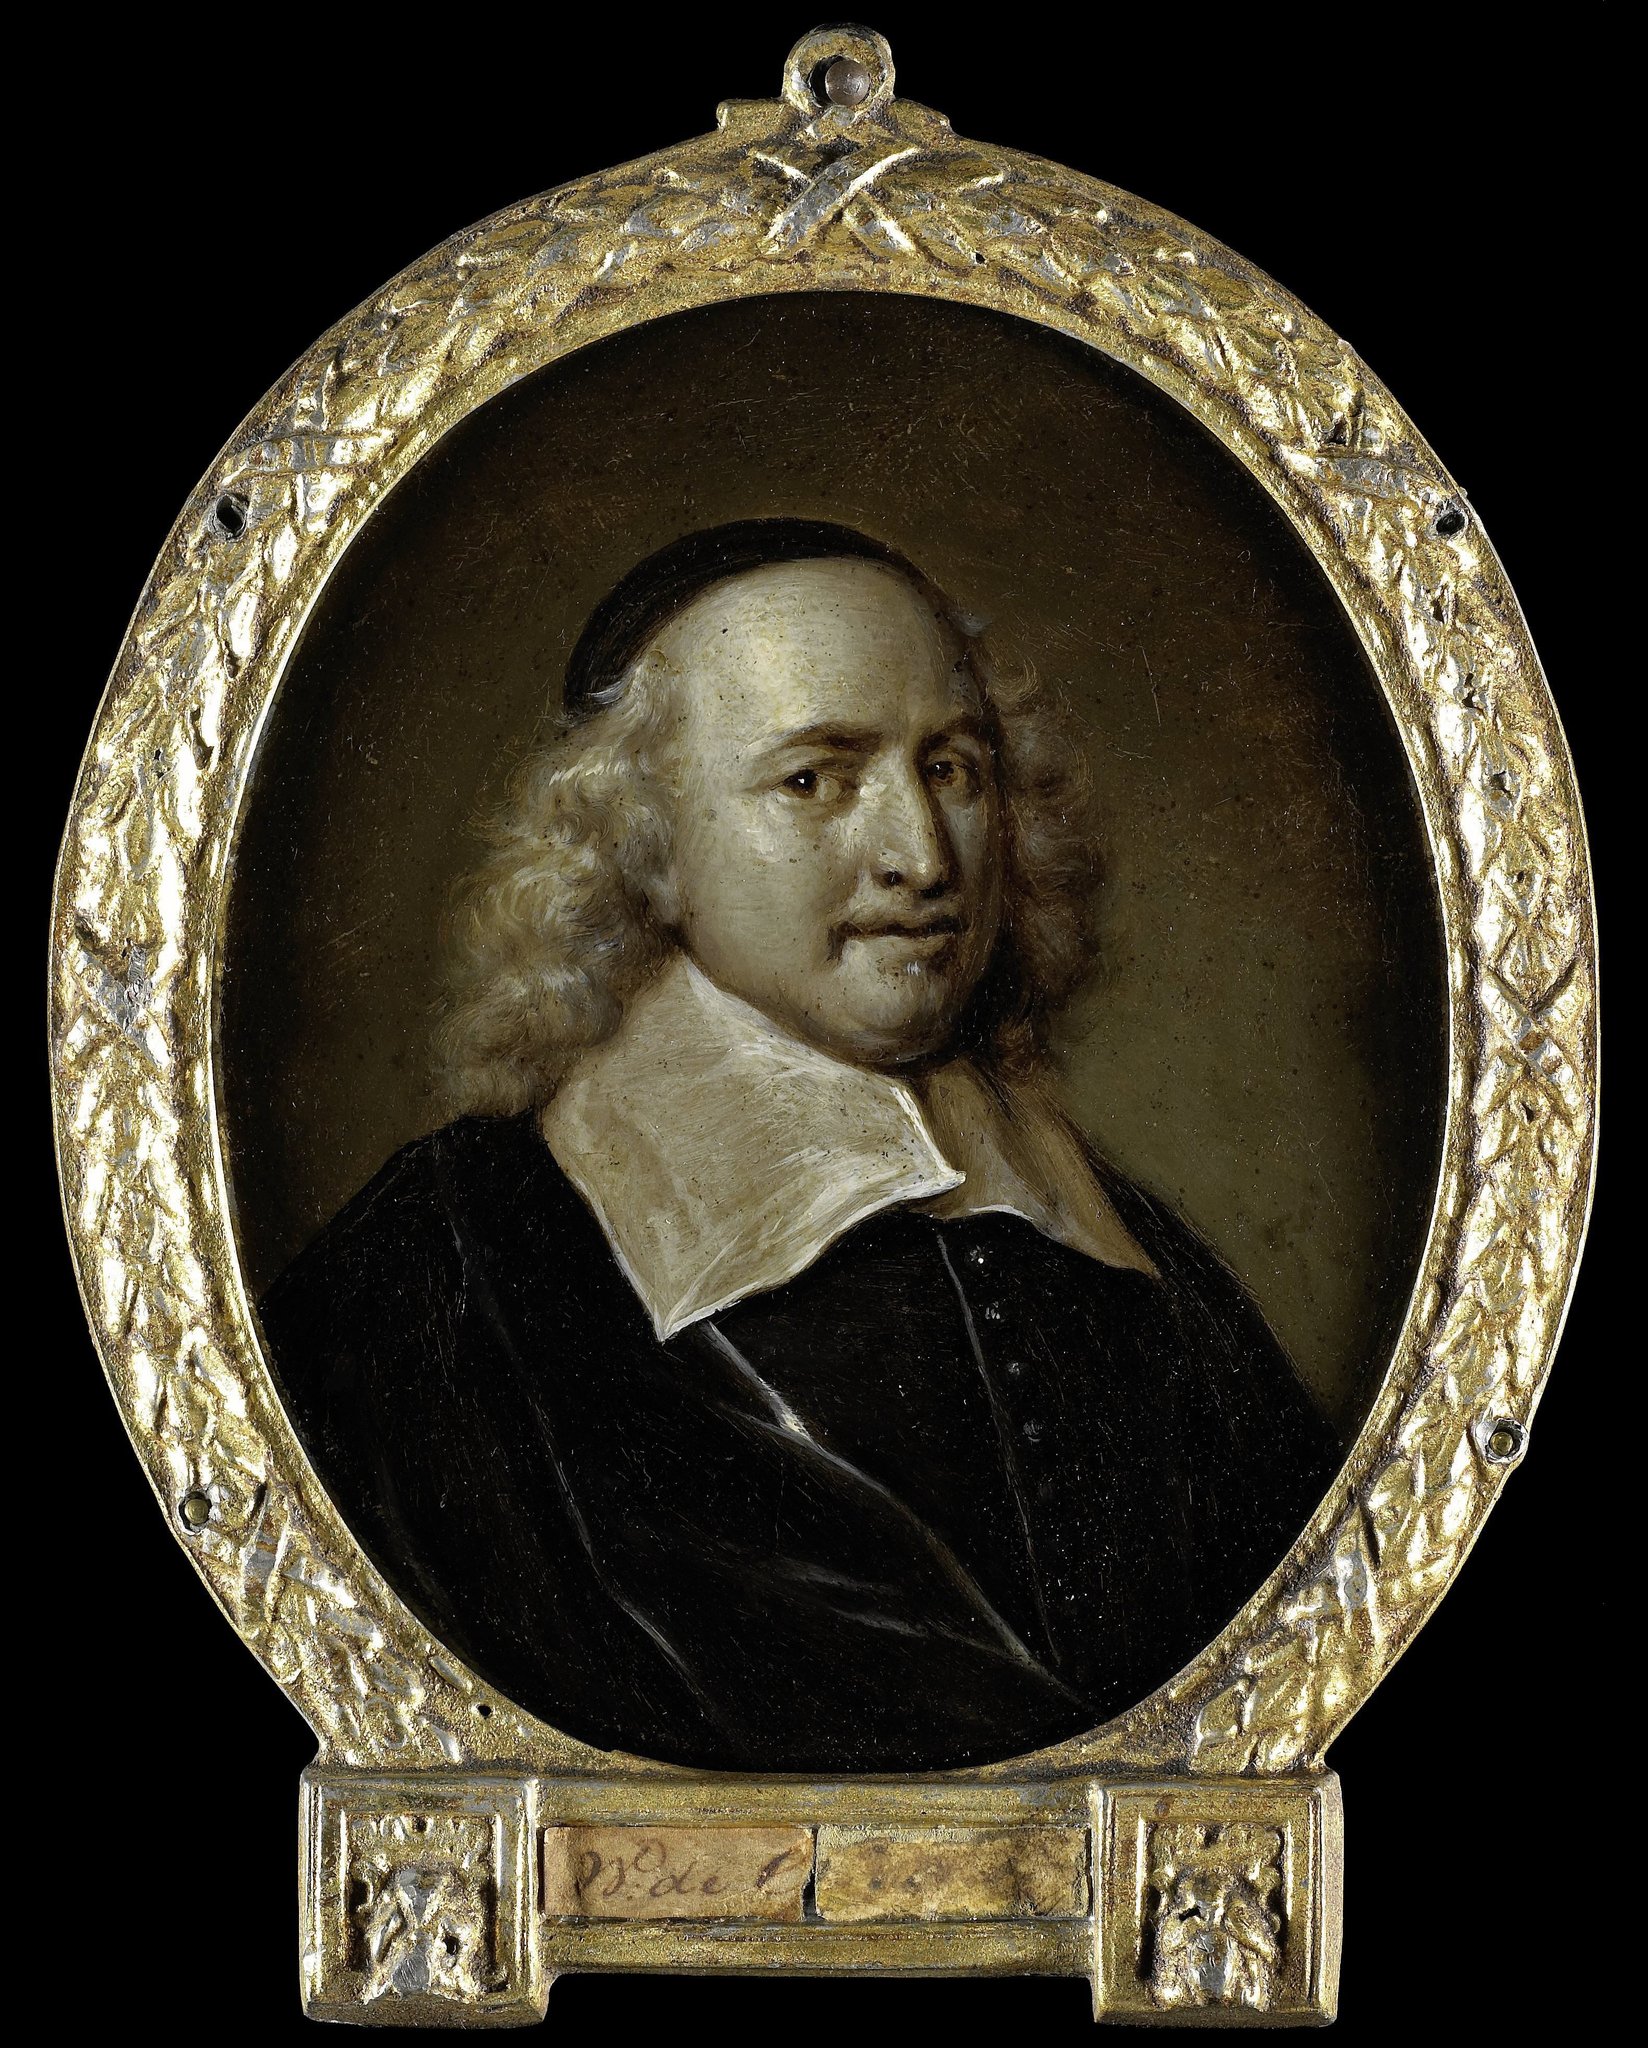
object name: painting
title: Portrait of Willem de Groot, Lawyer and Writer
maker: jan maurits quinkhard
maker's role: draughtsman, painter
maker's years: 1688-1772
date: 1732-1771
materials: copper, oil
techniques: grisaille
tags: delft, willem de groot (1597-1662), portrait of a writer, writer, poet, author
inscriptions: inscription: ‘Wilh. Grotius Aº 1597’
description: Portret van Willem de Groot (1597-1662). Rechtsgeleerde en letterkundige. Buste in ovaal, naar rechts. Onderdeel van een verzameling portretten van Nederlandse dichters.